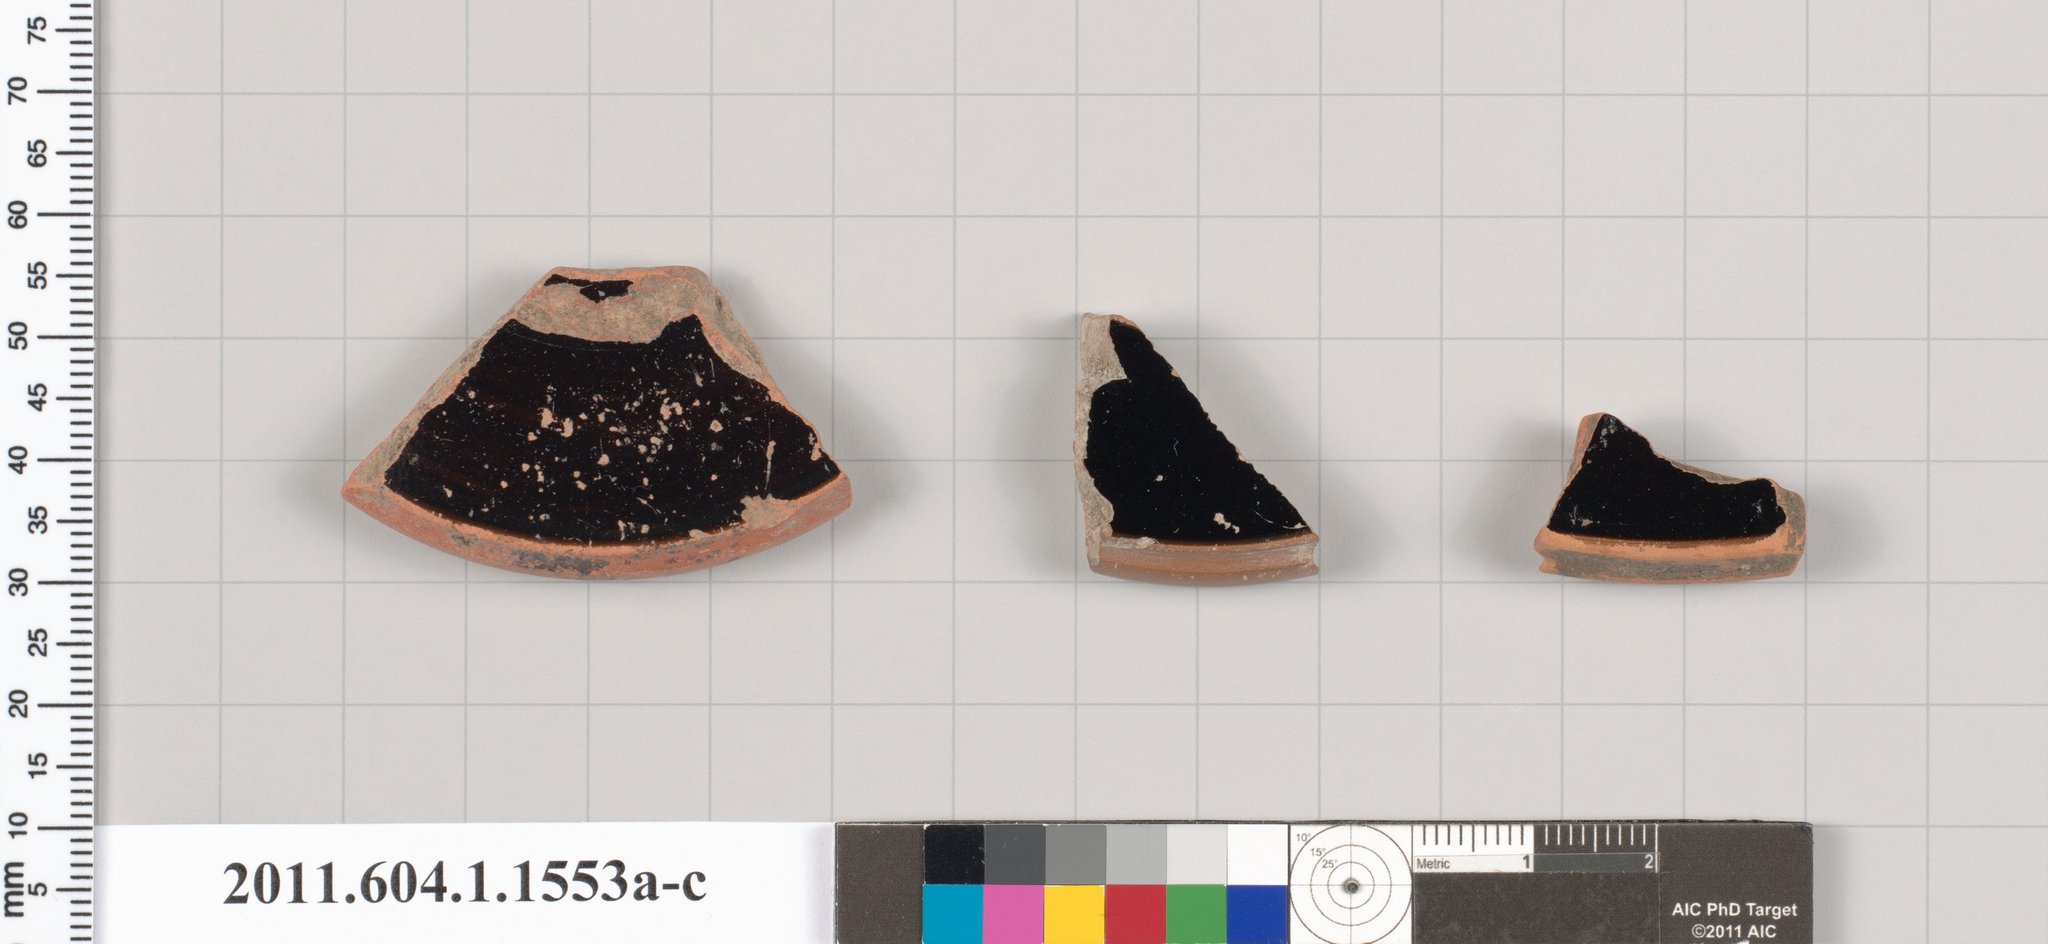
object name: kylix fragment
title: Terracotta fragments of kylikes (drinking cups)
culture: greek, attic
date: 500-401 BCE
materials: terracotta